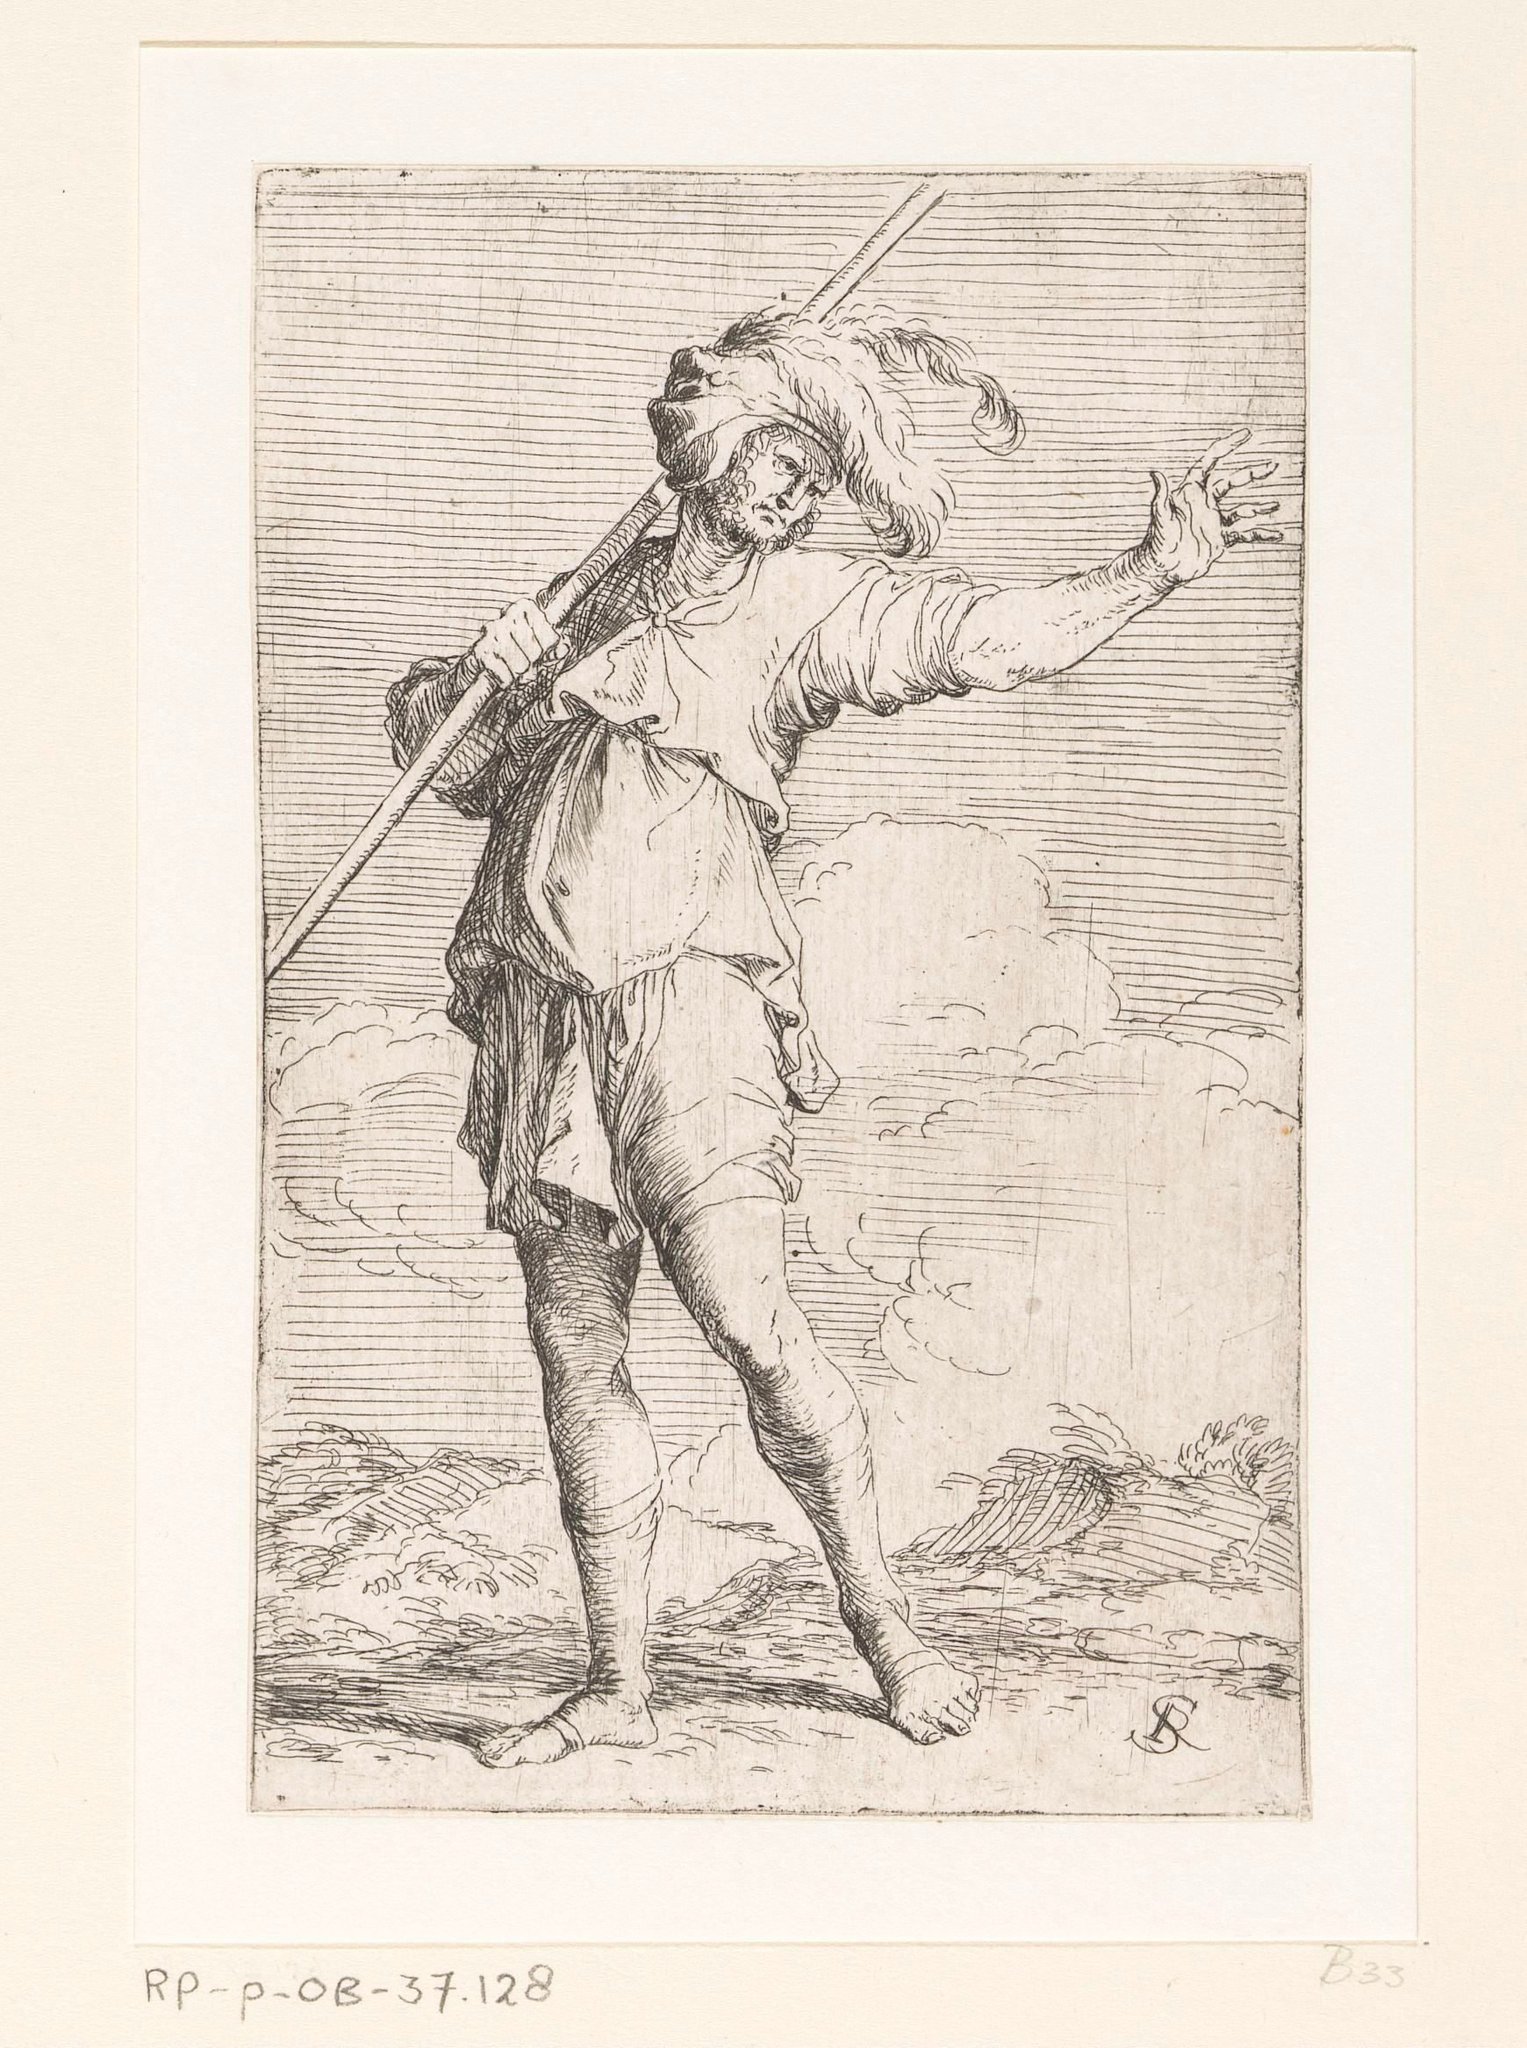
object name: print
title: Figurine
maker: salvator rosa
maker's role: draughtsman, painter, print maker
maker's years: 1615-1673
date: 1656-1657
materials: paper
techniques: drypoint, etching, intaglio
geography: italy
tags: walking-stick, staff, the soldier; the soldier's life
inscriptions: number: ‘33’, collector's mark: Lugt 240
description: Deze prent maakt deel uit van de serie 'Figurine', bestaande uit een titelprent en 80 prenten van klein formaat met voorstellingen van mannelijke en vrouwelijke figuren. Rosa produceerde de serie waarschijnlijk gedurende de jaren 1656 en 1657.